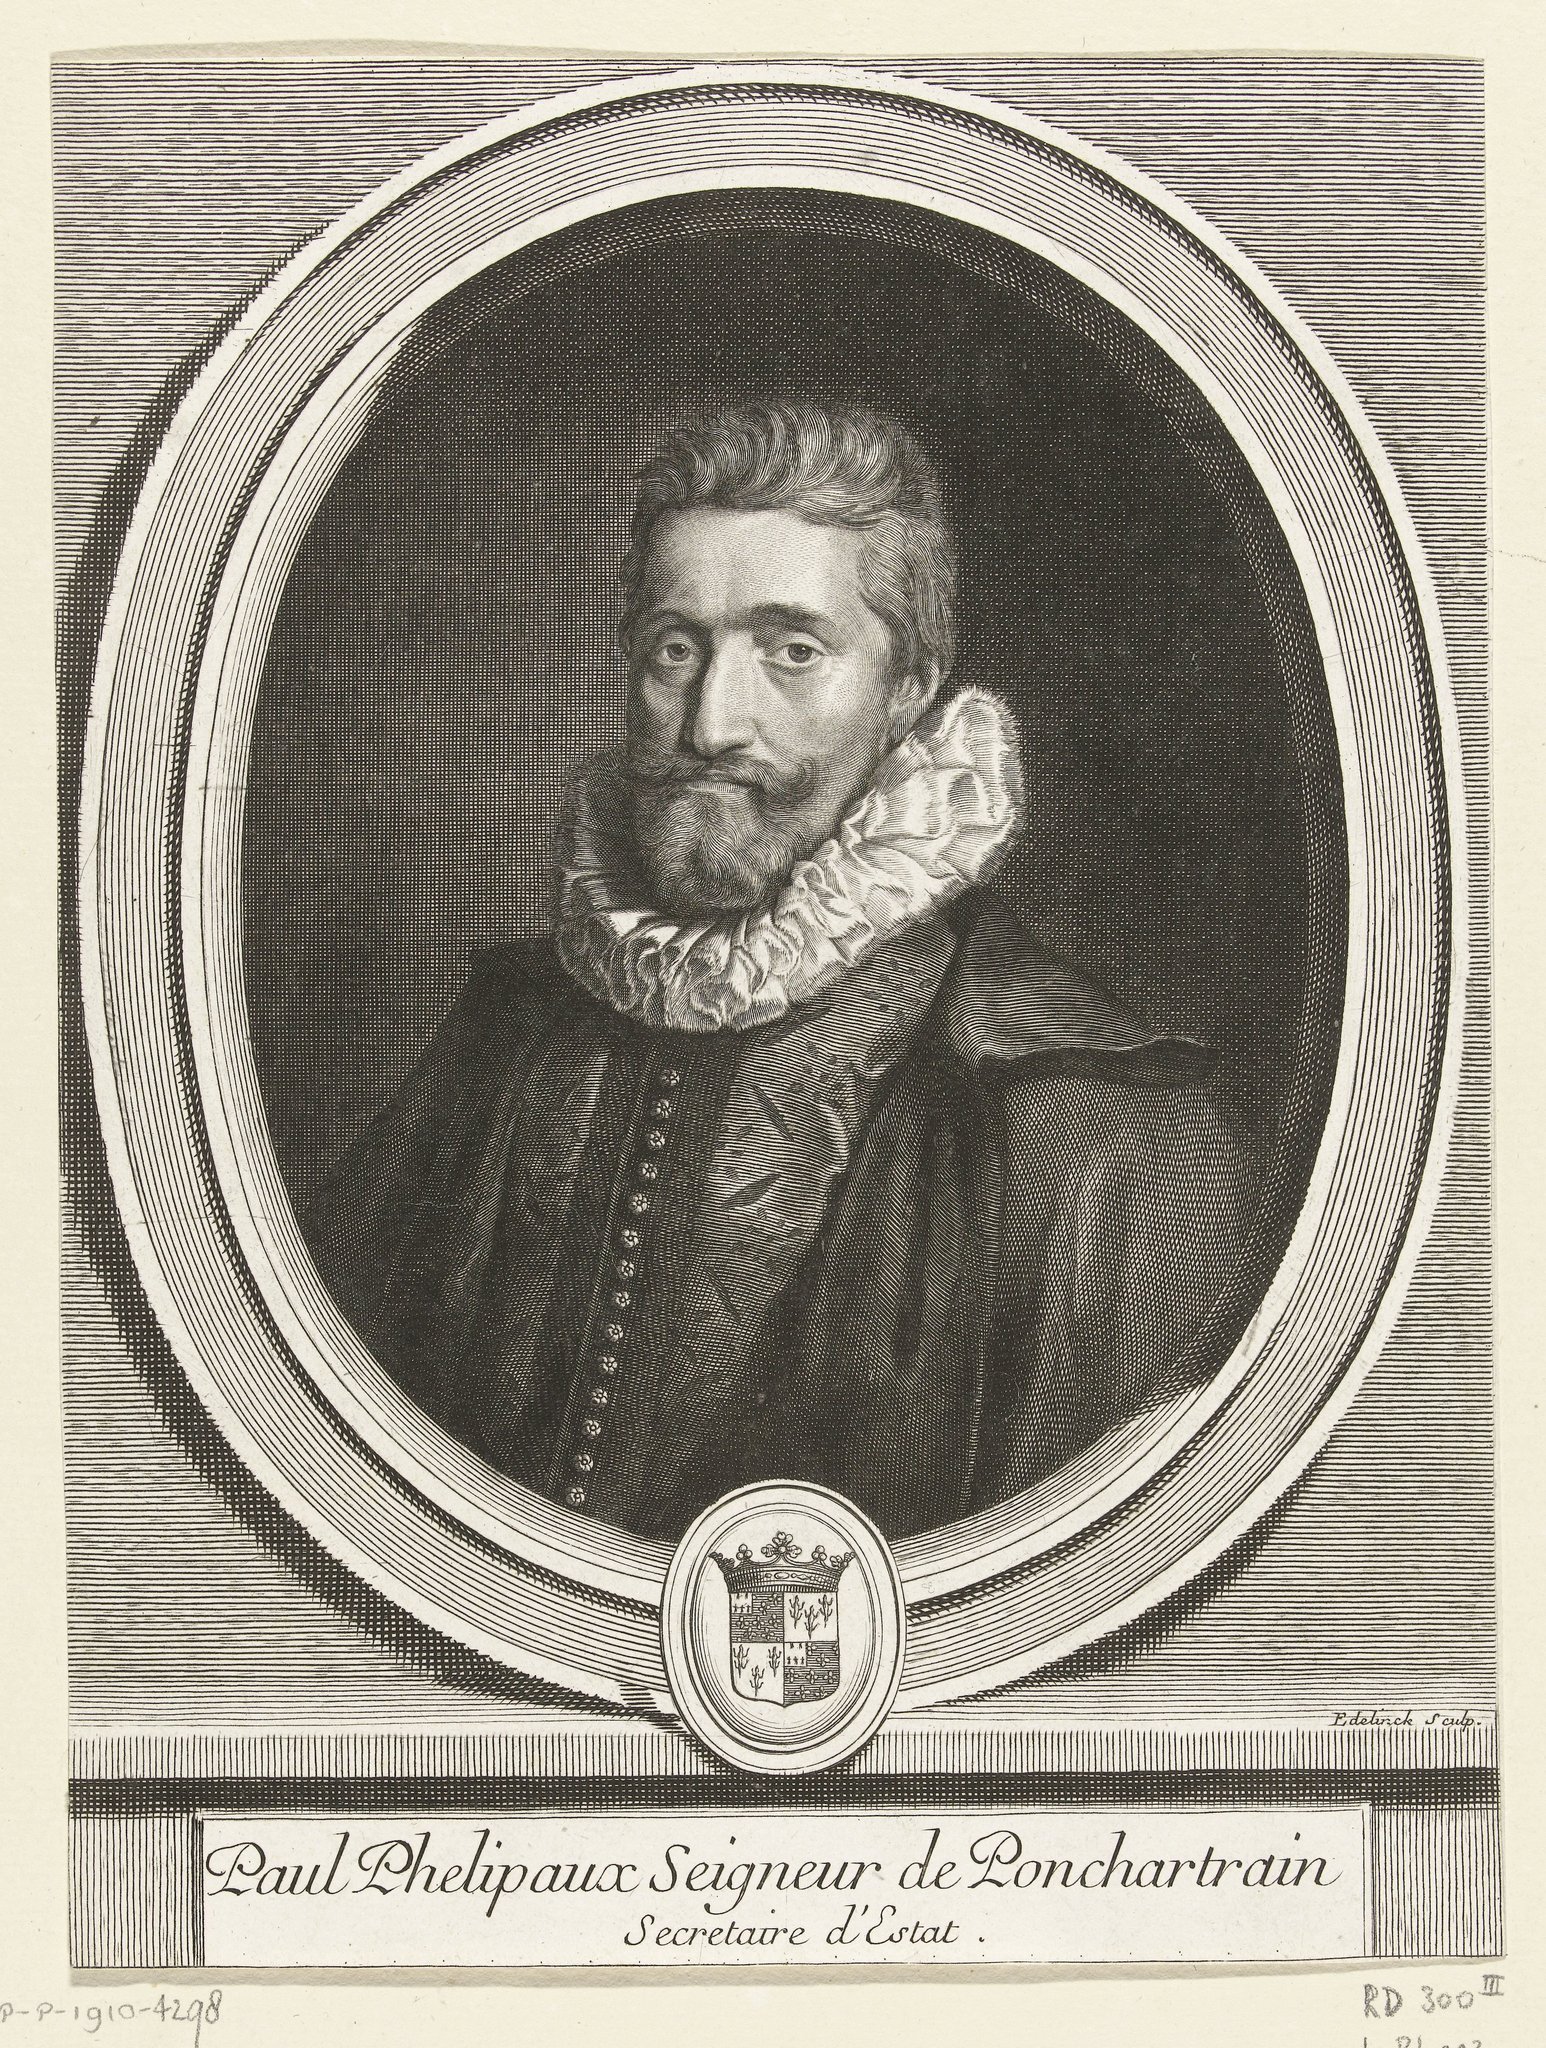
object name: print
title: Portret van Paul Phélypeaux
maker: gerard edelinck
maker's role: print maker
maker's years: 1640-1707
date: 1652-1707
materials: paper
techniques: engraving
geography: france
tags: staatsman, paul phélypeaux de ponchartrain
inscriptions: collector's mark: Lugt 2228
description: Portret van de Franse staatsman Paul Phélypeaux (1569-1621), afgebeeld in ovale omlijsting met wapen.